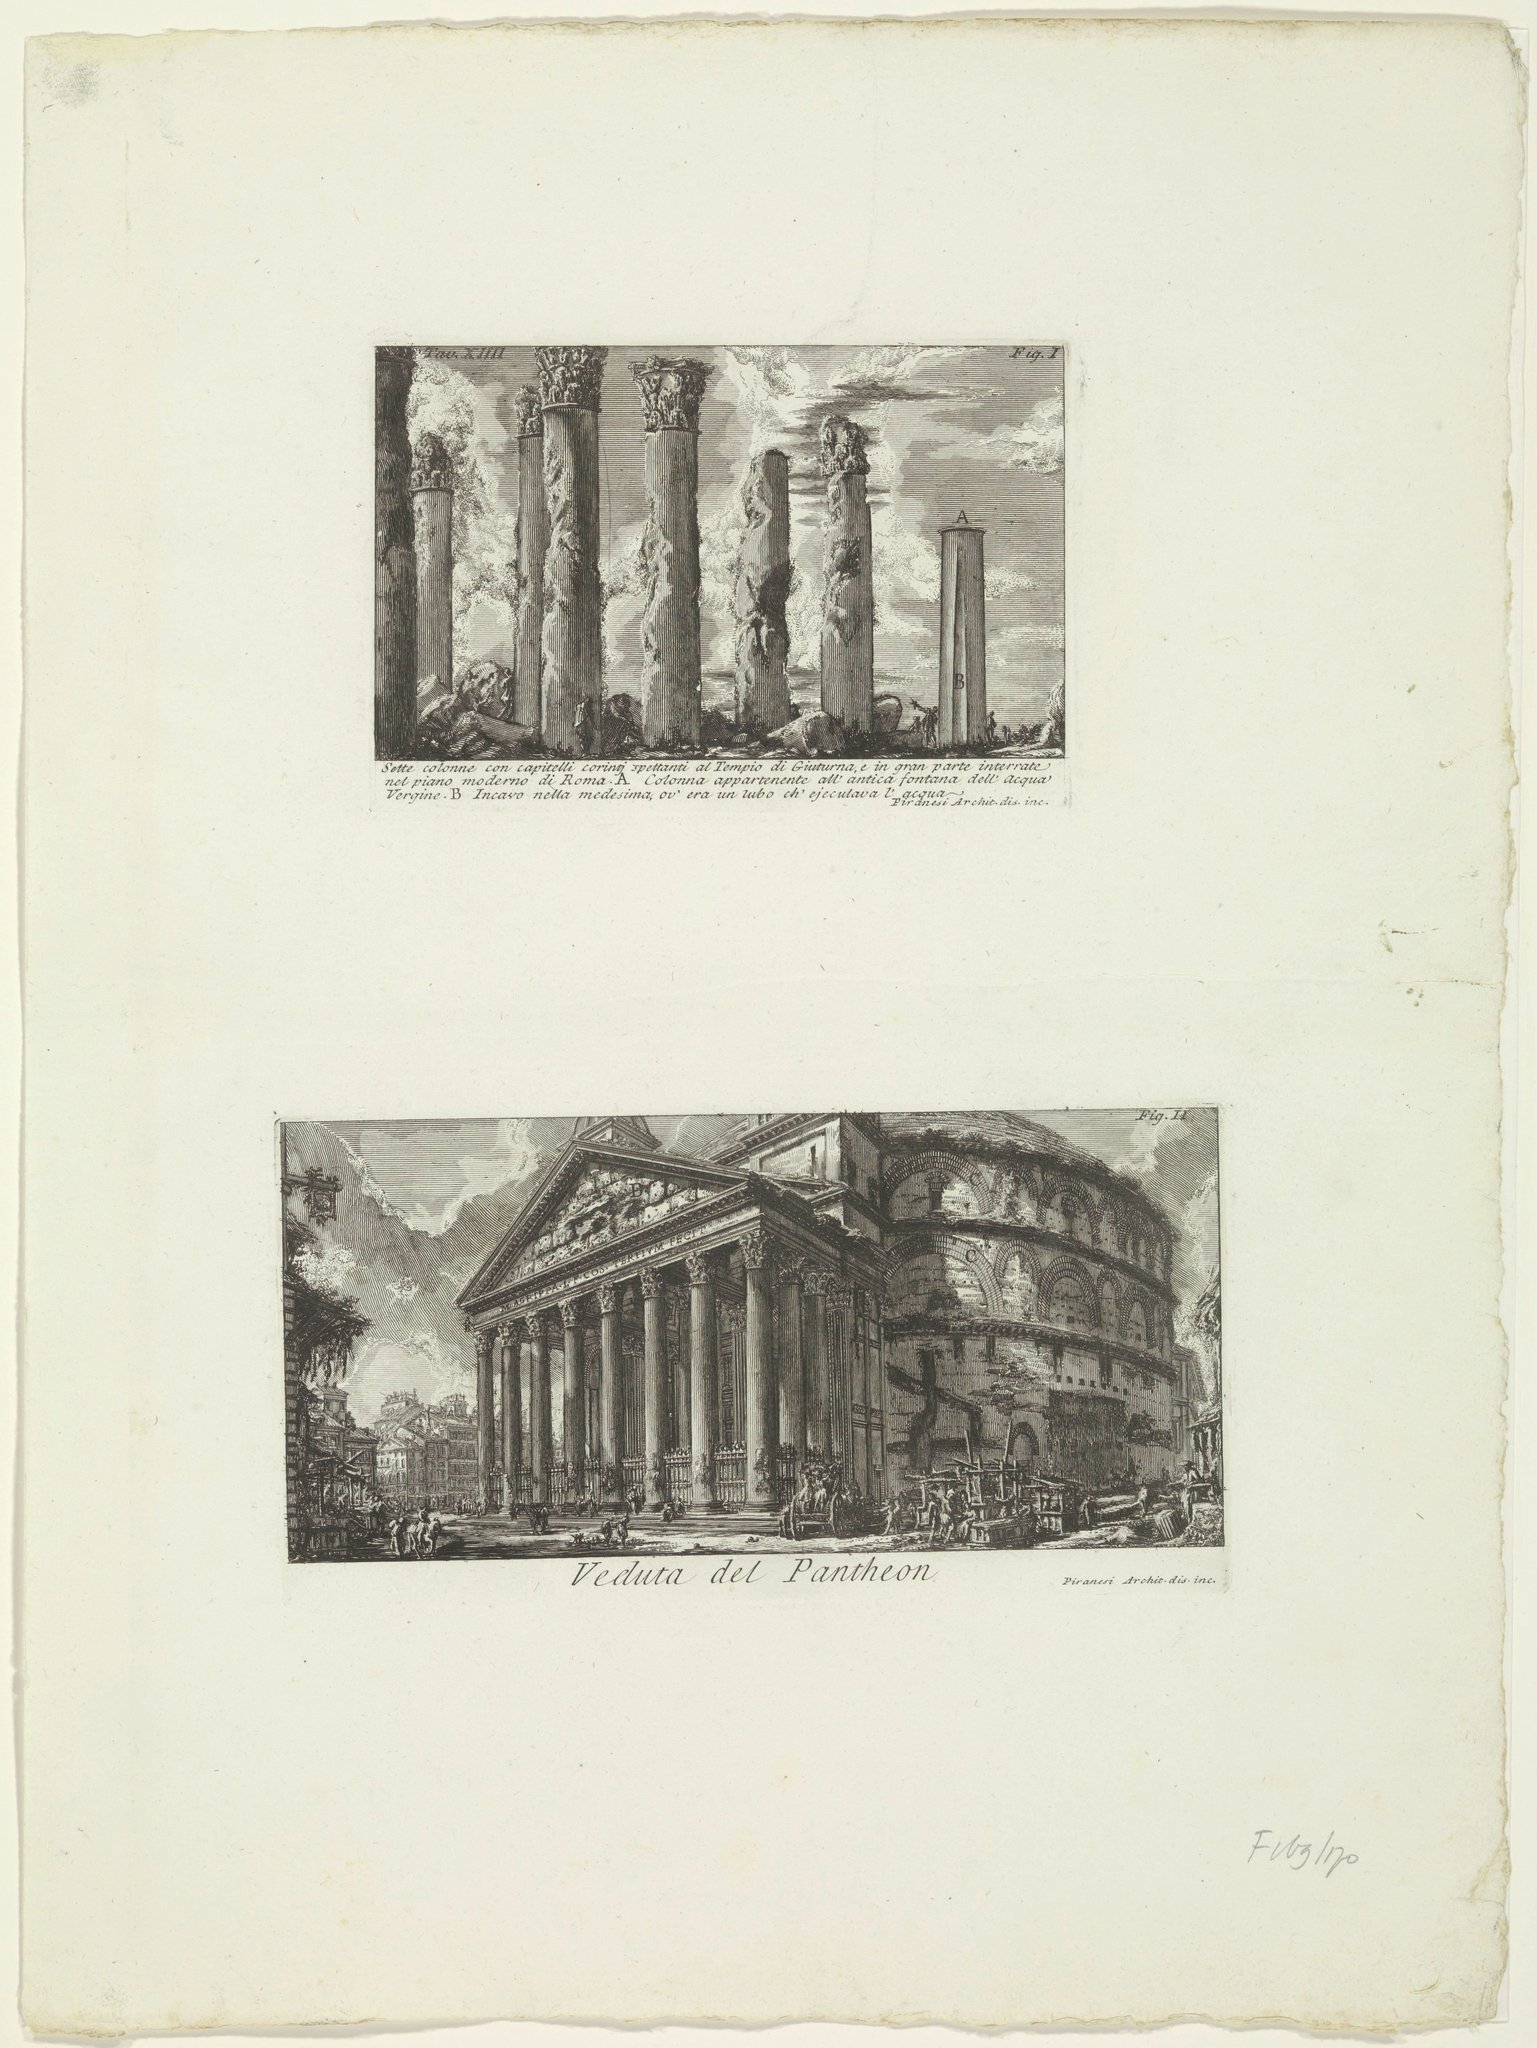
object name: print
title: Veduta del Pantheon (onder)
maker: giovanni battista piranesi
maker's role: designer, draughtsman, print maker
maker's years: 1720-1778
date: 1756-1757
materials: paper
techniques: etching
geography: rome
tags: temple, shrine ~ roman religion, corinthian order ~ architecture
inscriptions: collector's mark: Lugt 2228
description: Blad met twee voorstellingen van Romeinse bouwwerken. Boven: zeven Korinthische zuilen, volgens het onderschrift restanten van de Tempel van Juturna. Rechts een achtste zuil zonder kapiteel. Genummerd linksboven: Tav. XIIII. Genummerd rechtsboven: Fig. I. Titel en verklarende lijst in ondermarge. Onder: gezicht op het Pantheon. Genummerd rechtsboven: Fig. II. Titel in ondermarge.